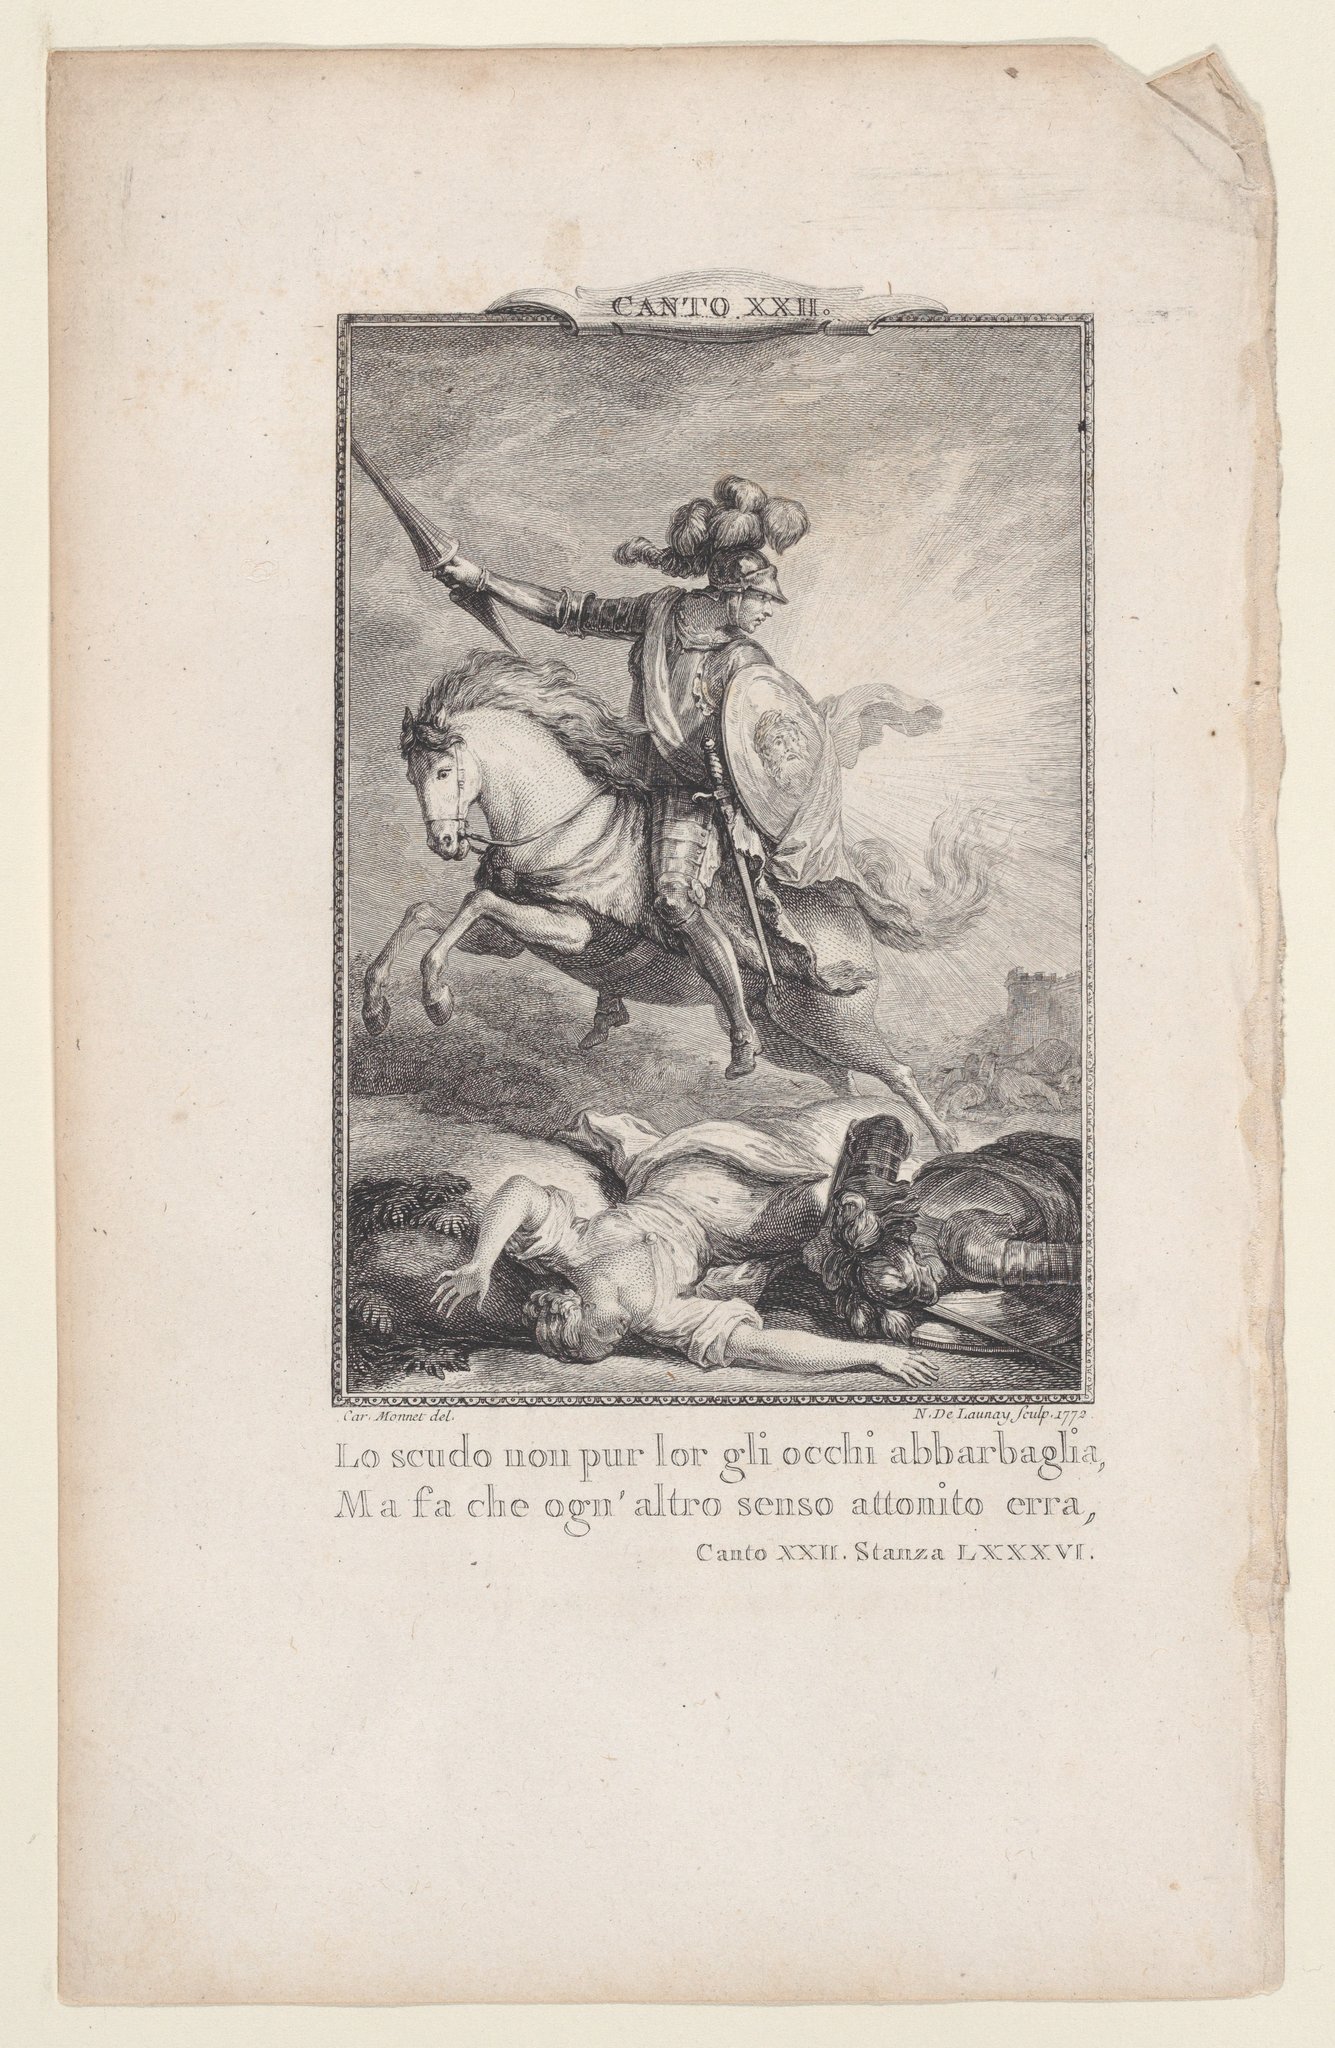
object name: print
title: Canto 22, Stanza 86, from "Orlando Furioso"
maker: nicolas de launay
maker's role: artist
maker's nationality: french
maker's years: 1739-1792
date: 1772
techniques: engraving, etching